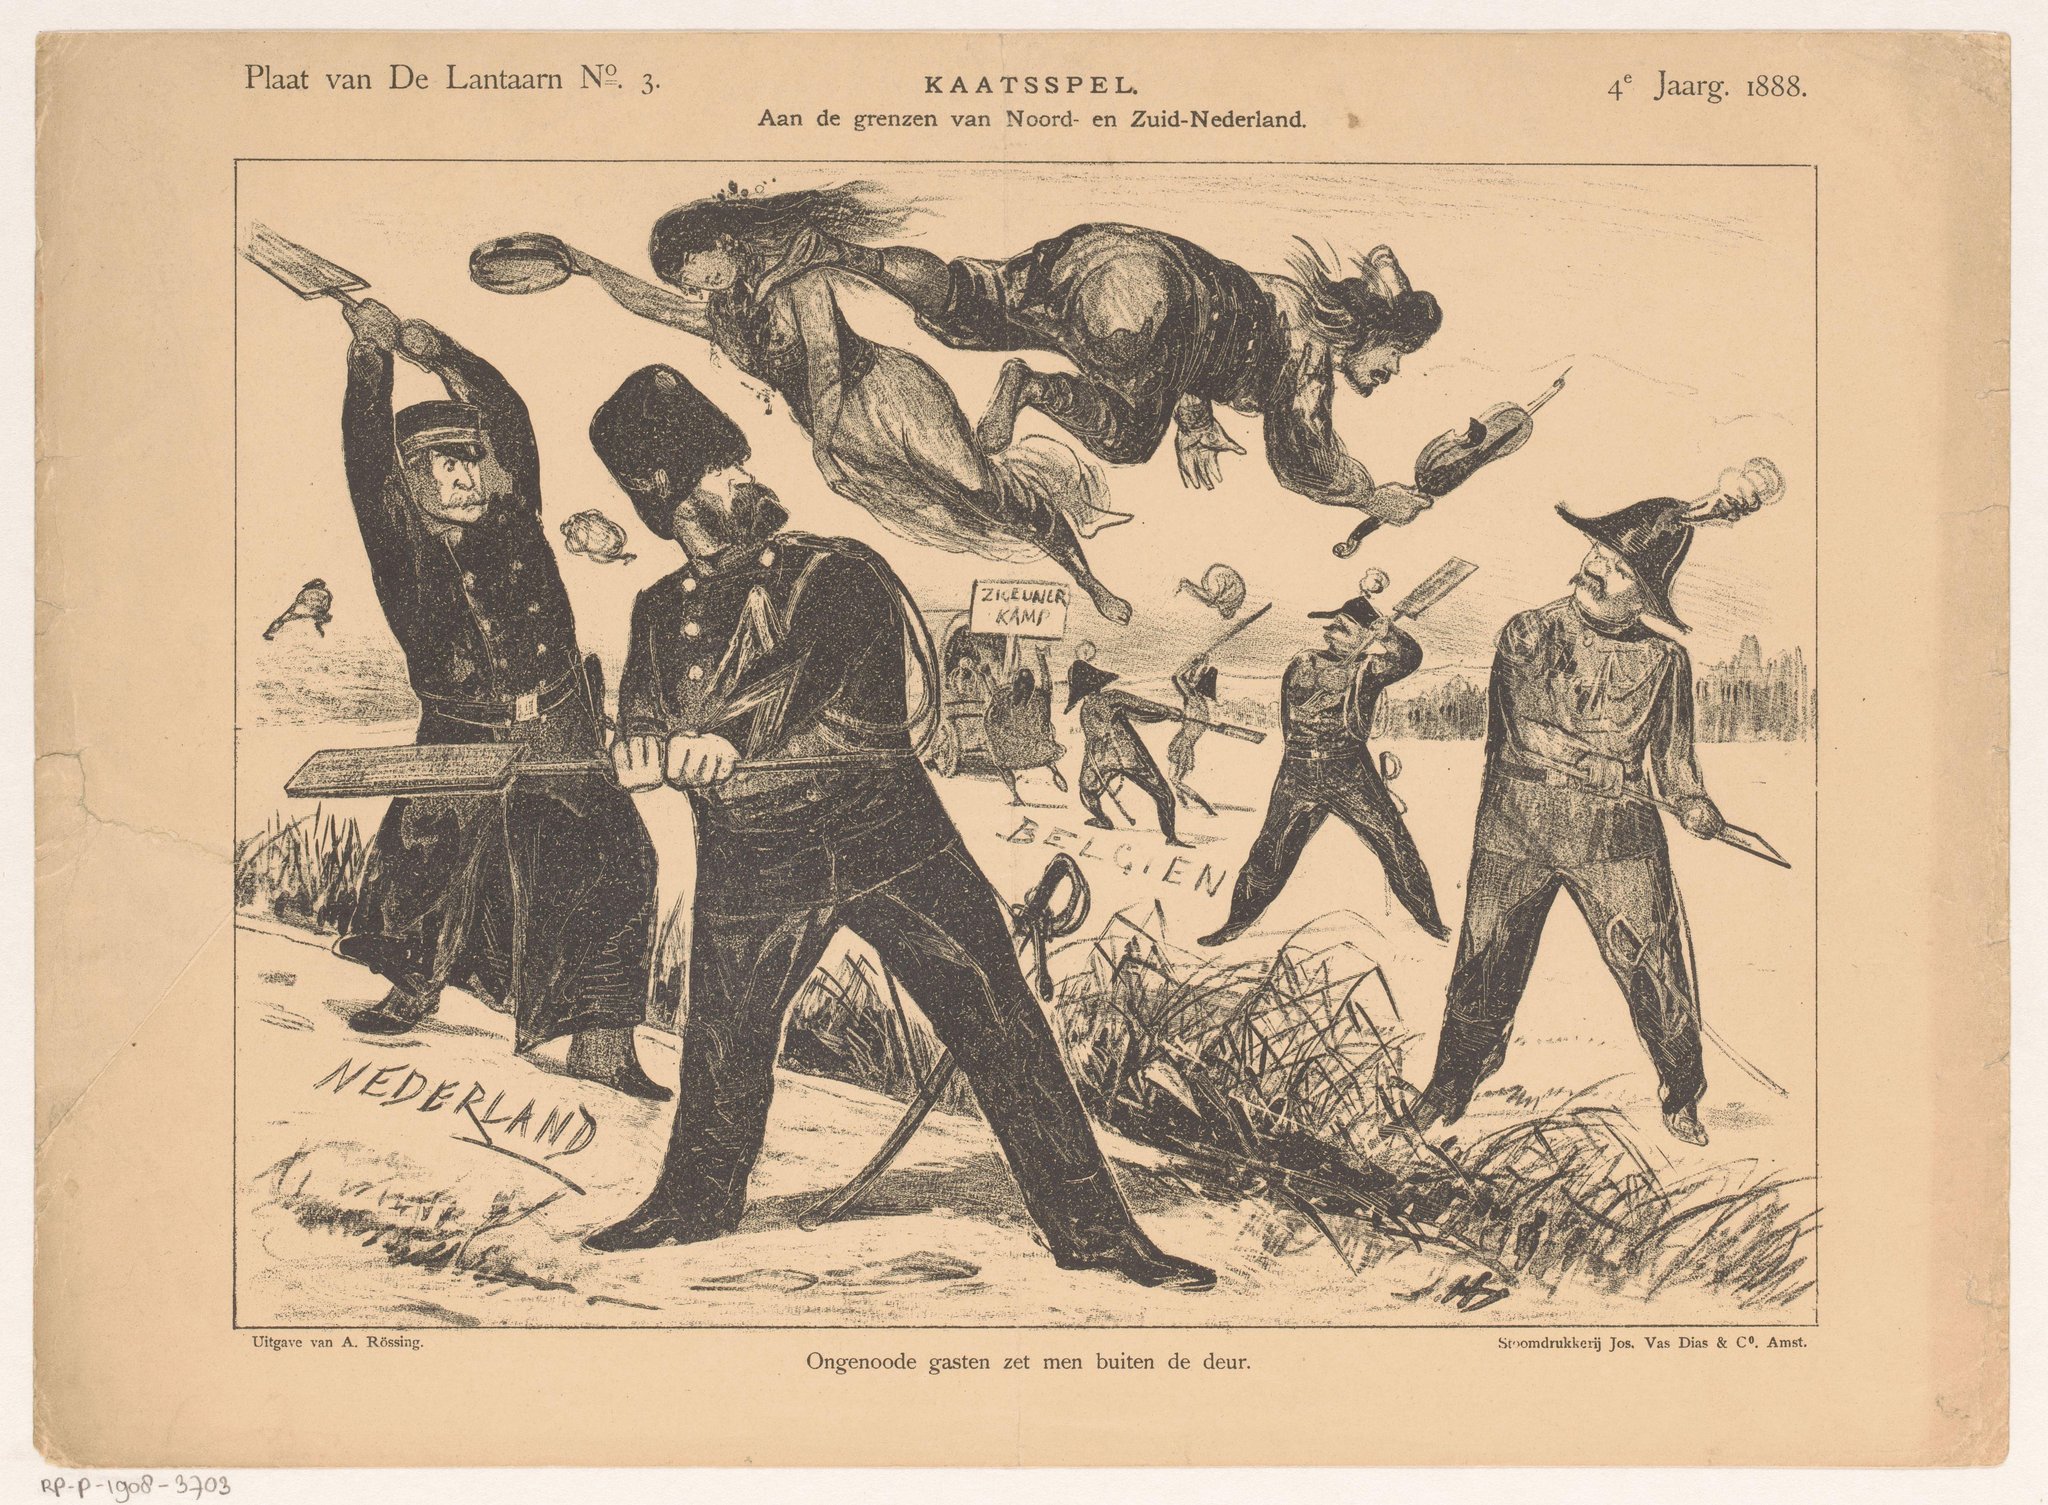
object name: cartoon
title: Spotprent over het beleid ten overstaan van zigeuners in Nederland en België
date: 1888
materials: paper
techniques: lithograph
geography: amsterdam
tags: wandering communities: romani or roma, political caricatures and satires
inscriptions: collector's mark: Lugt 2228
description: Nederlandse en Belgische politie en officieren slaan met houten planken zigeuners naar elkaar de grens over. Deze prent werd uitgegeven bij De Lantaarn.